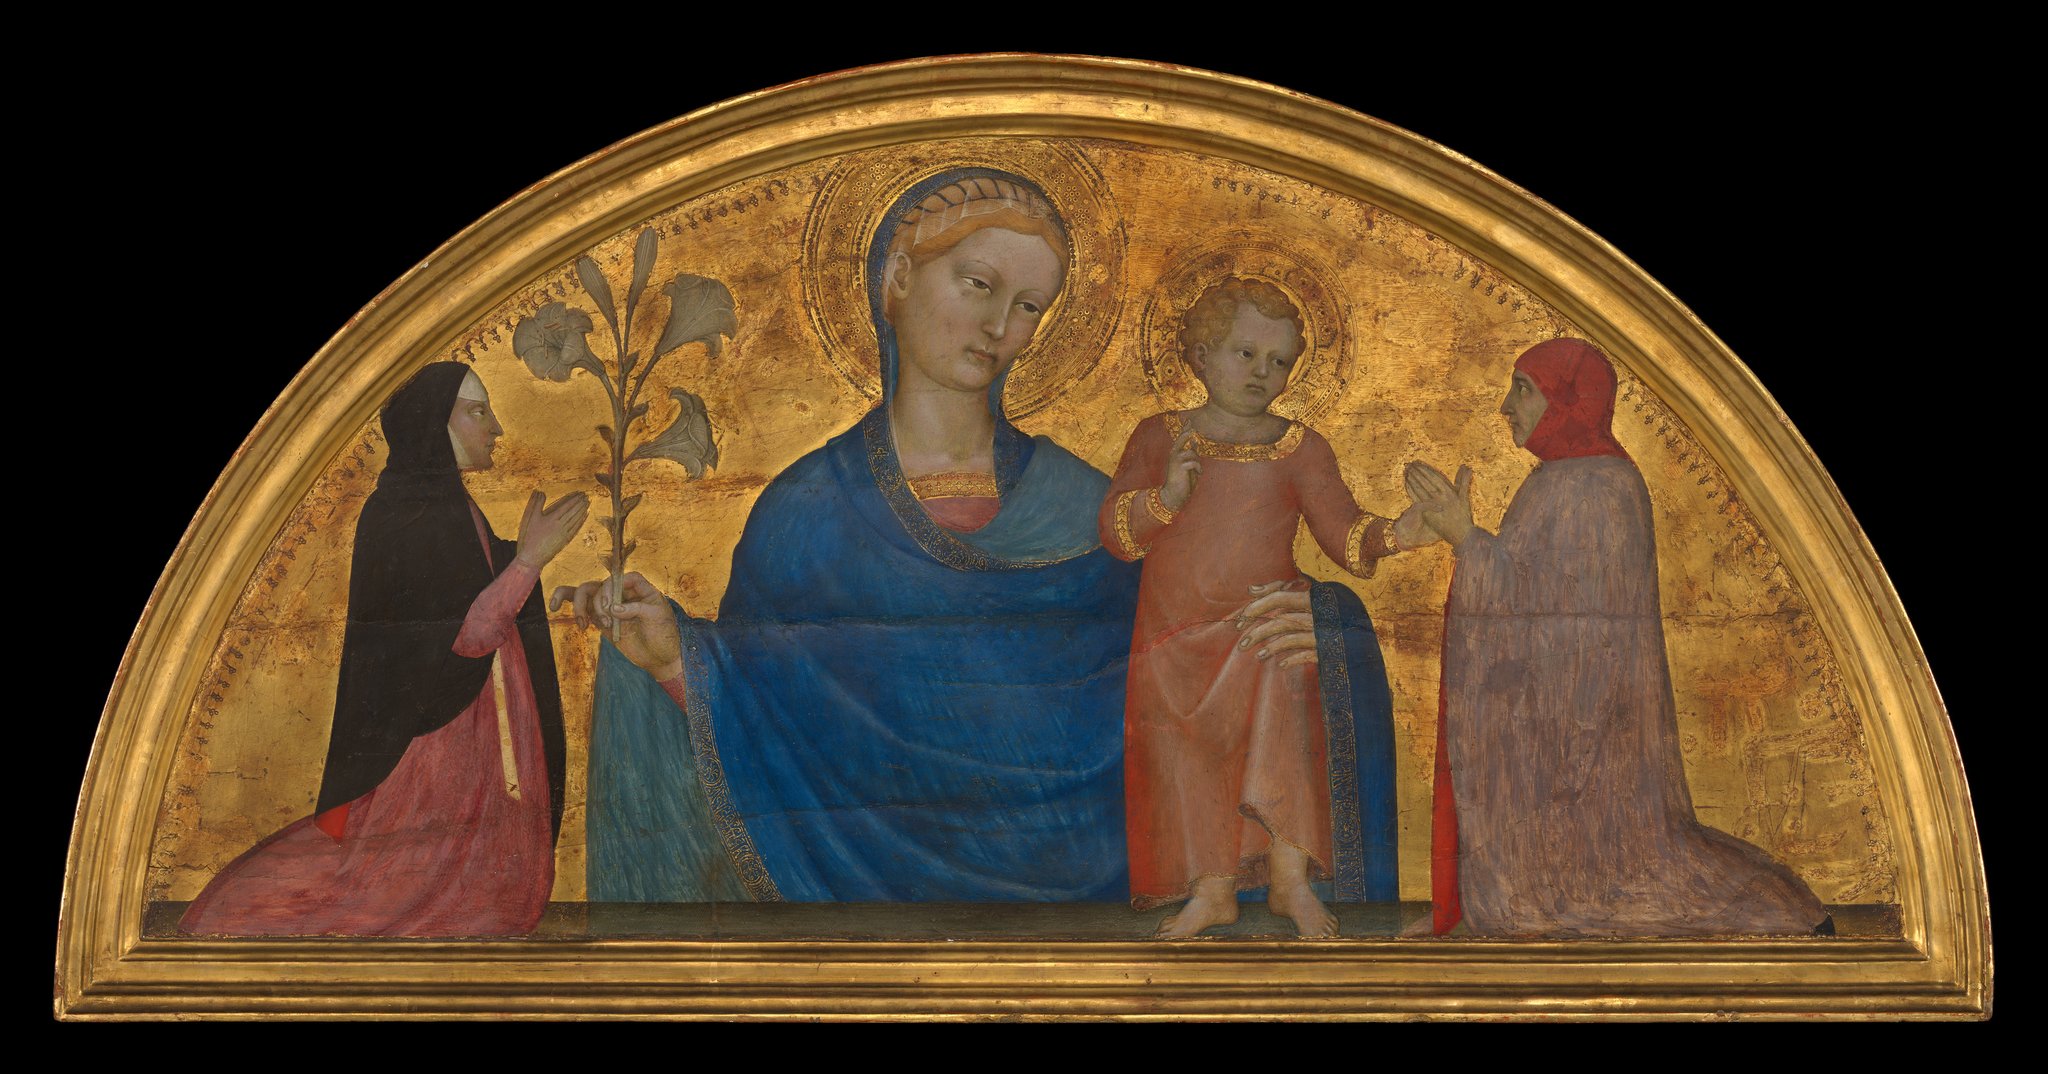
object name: painting, lunette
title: Madonna and Child with Donors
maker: giovanni da milano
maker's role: artist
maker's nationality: italian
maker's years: 1346-1369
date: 1365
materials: gold leaf, paint, wood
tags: women,lilies,madonna and child,jesus